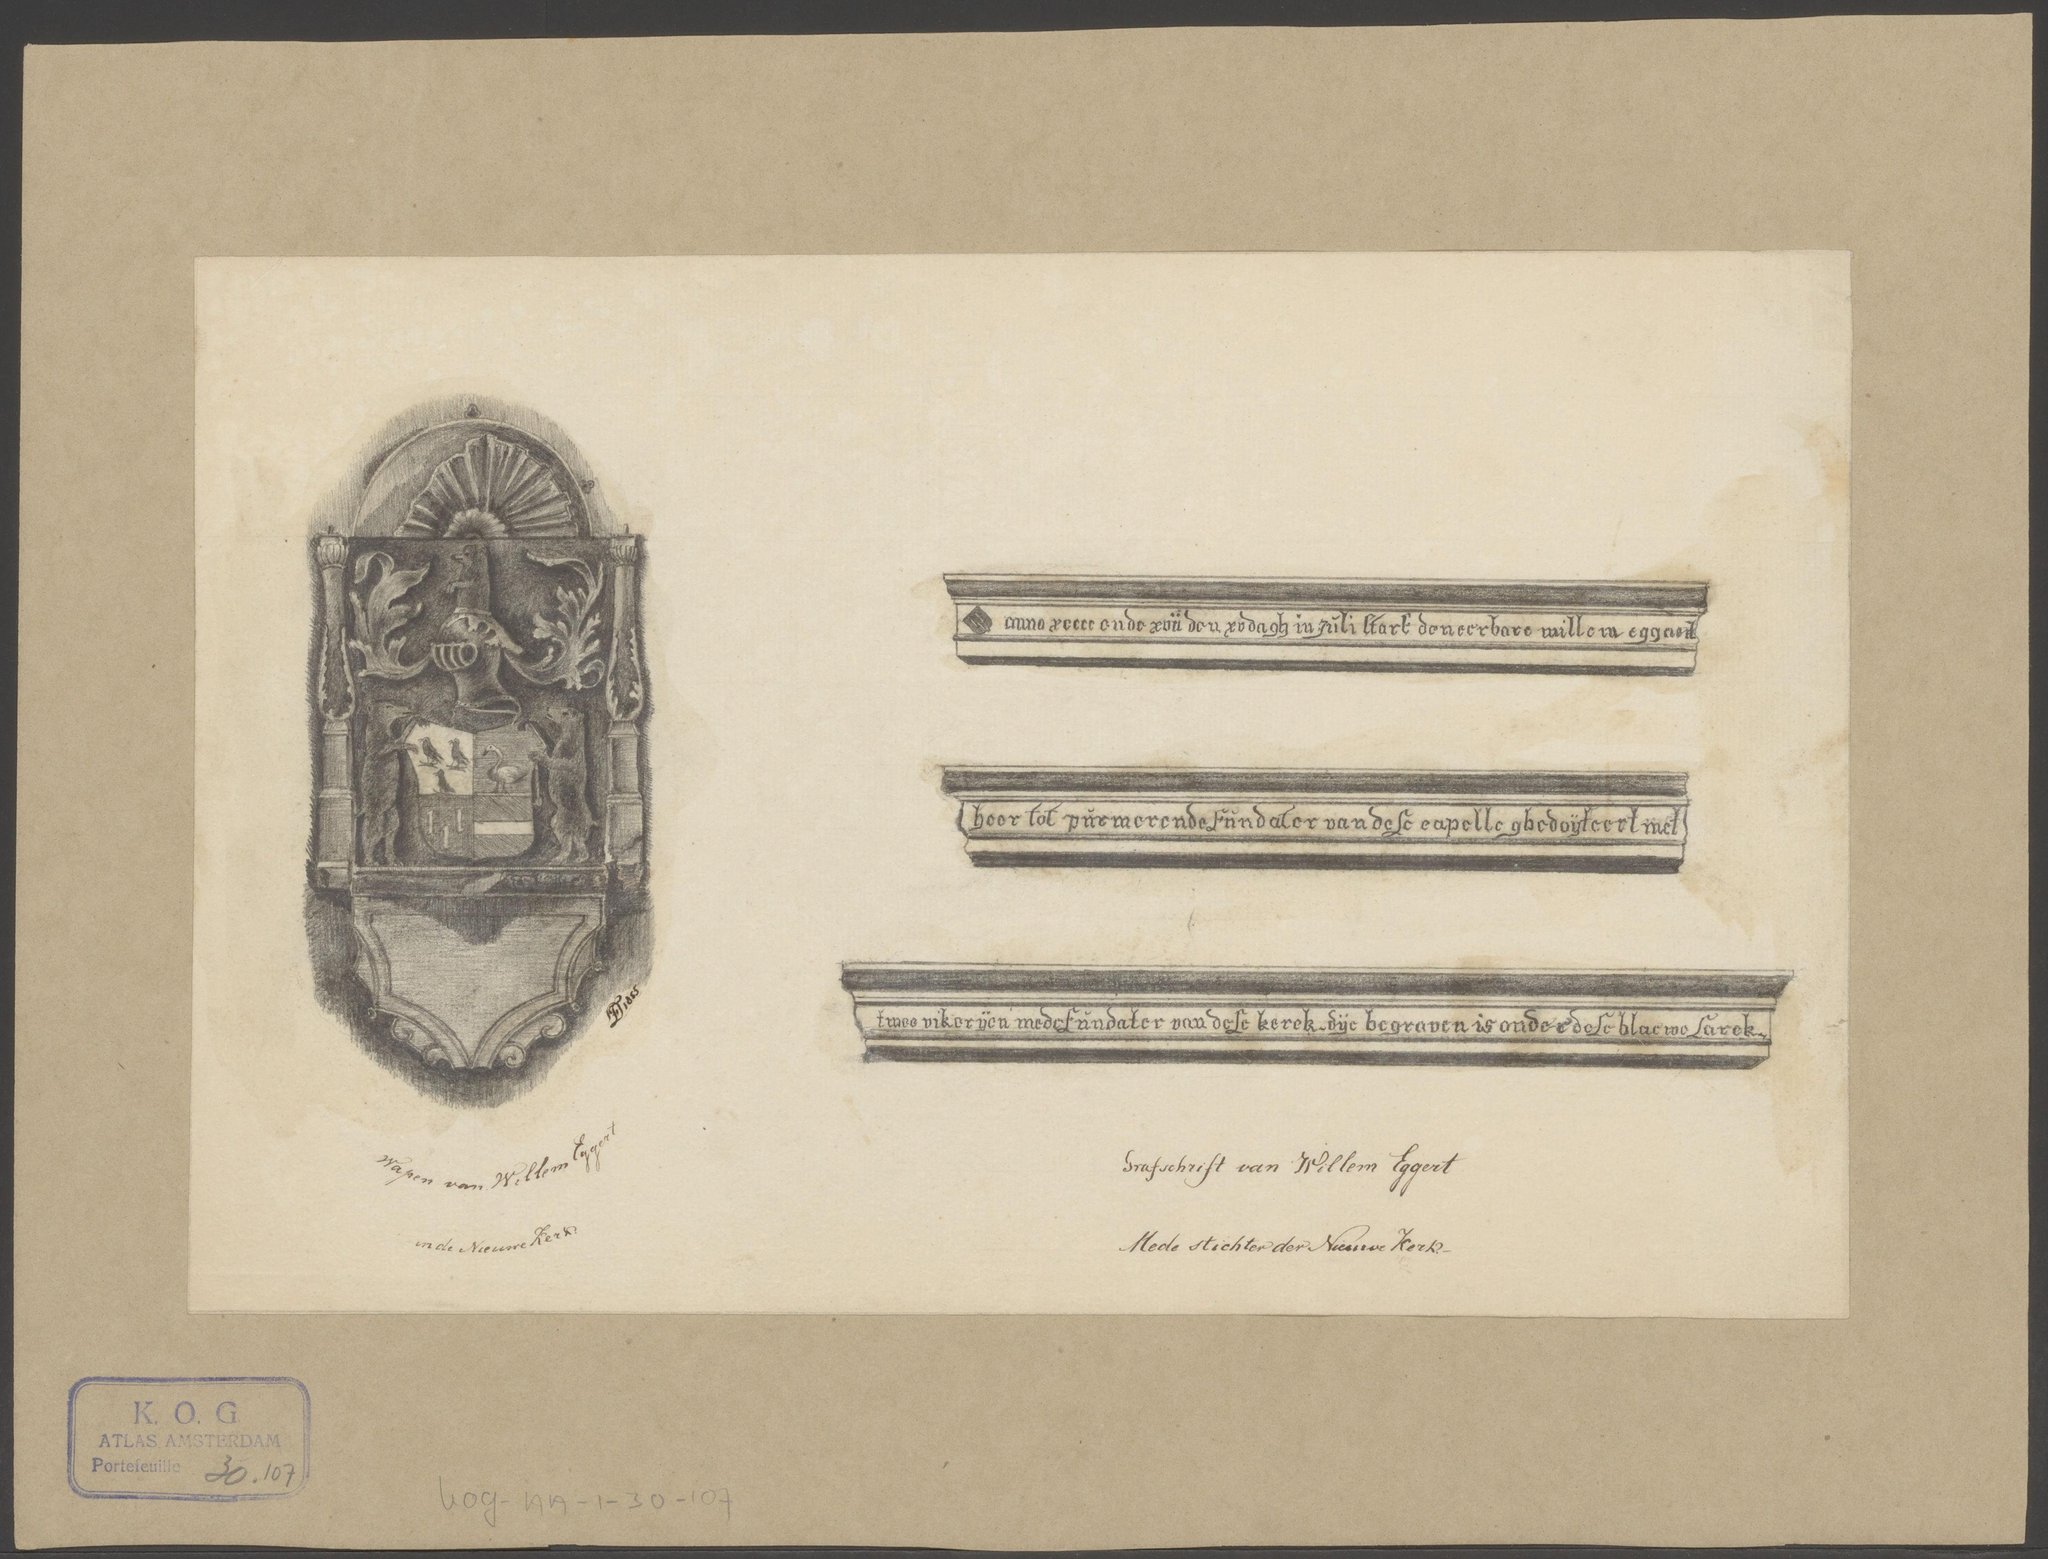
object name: drawing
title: Wapen van Willem Eggert in de Nieuwe Kerk / Grafschrift van Willem Eggert Mede stichter der Nieuwe Kerk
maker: Anonymous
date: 1855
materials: paper, pencil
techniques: drawing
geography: netherlands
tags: gravestone, tombstone, armorial bearing, heraldry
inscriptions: collector's mark: Lugt 1641b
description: Onderwerpsrubriek binnen de Atlas Amsterdam: Kerkwezen: Hervormde Gemeente: Nieuwe Kerk van binnen.